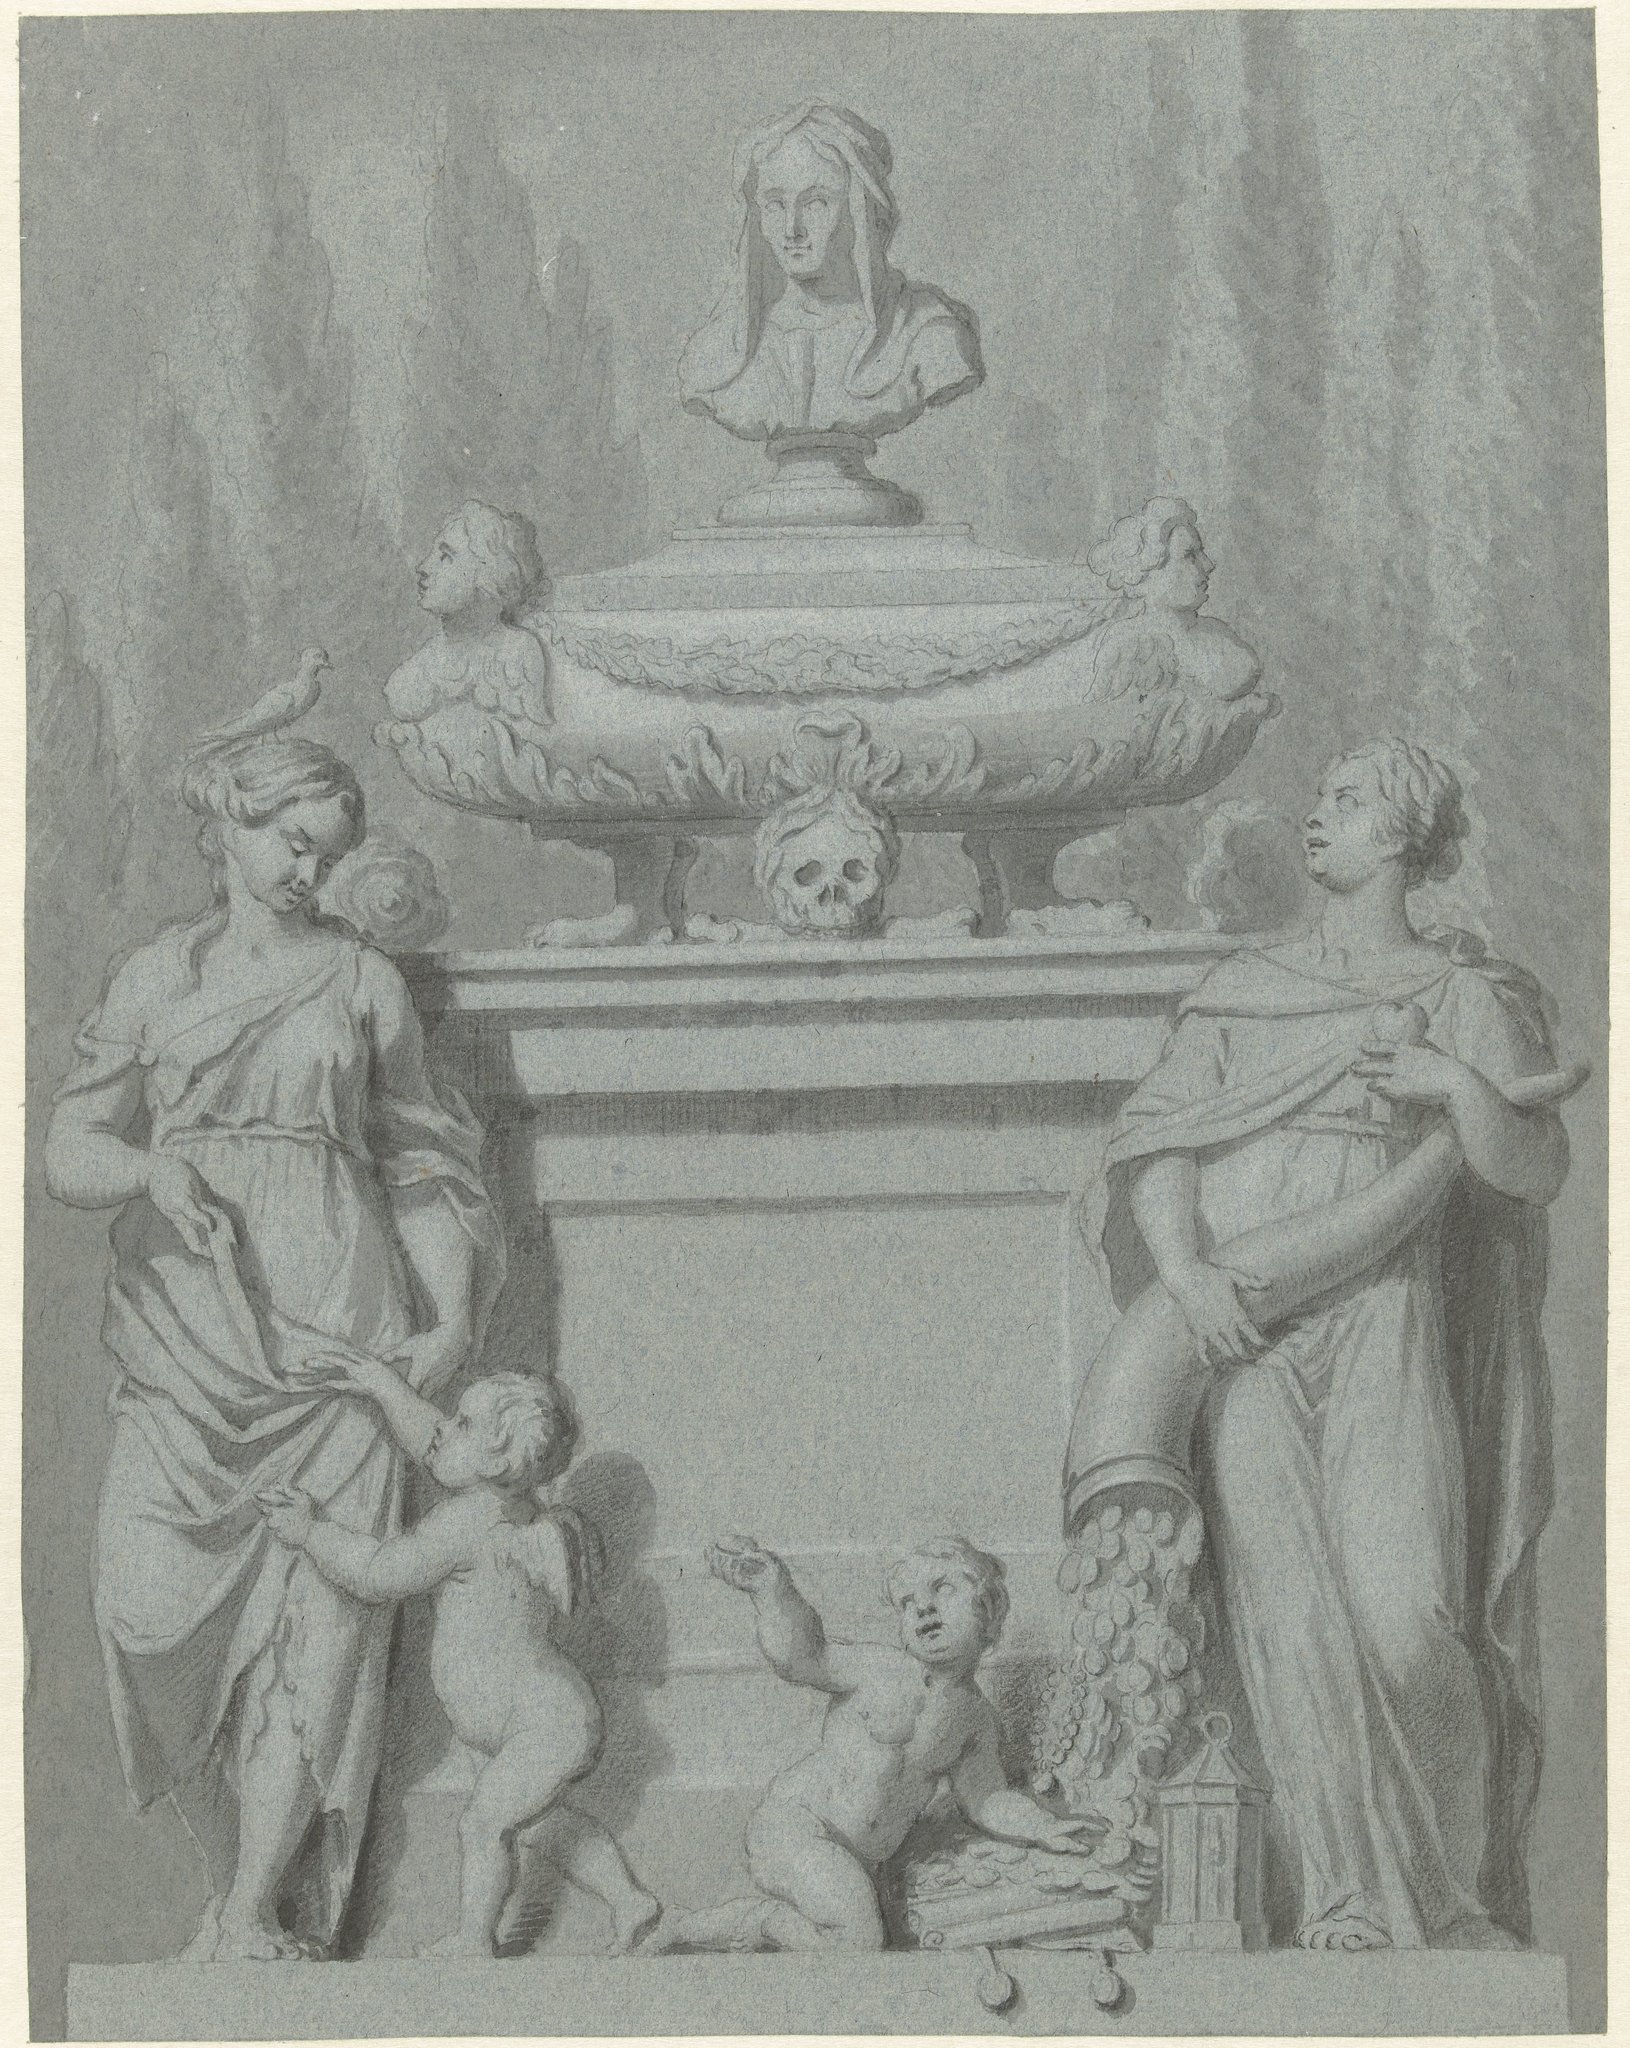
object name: design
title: Ontwerp voor een grafmonument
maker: frans decker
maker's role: draughtsman, painter, print maker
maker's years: 1684-1751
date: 1694-1751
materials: ink, paper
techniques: brush, pen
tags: grave-building, monumental tomb